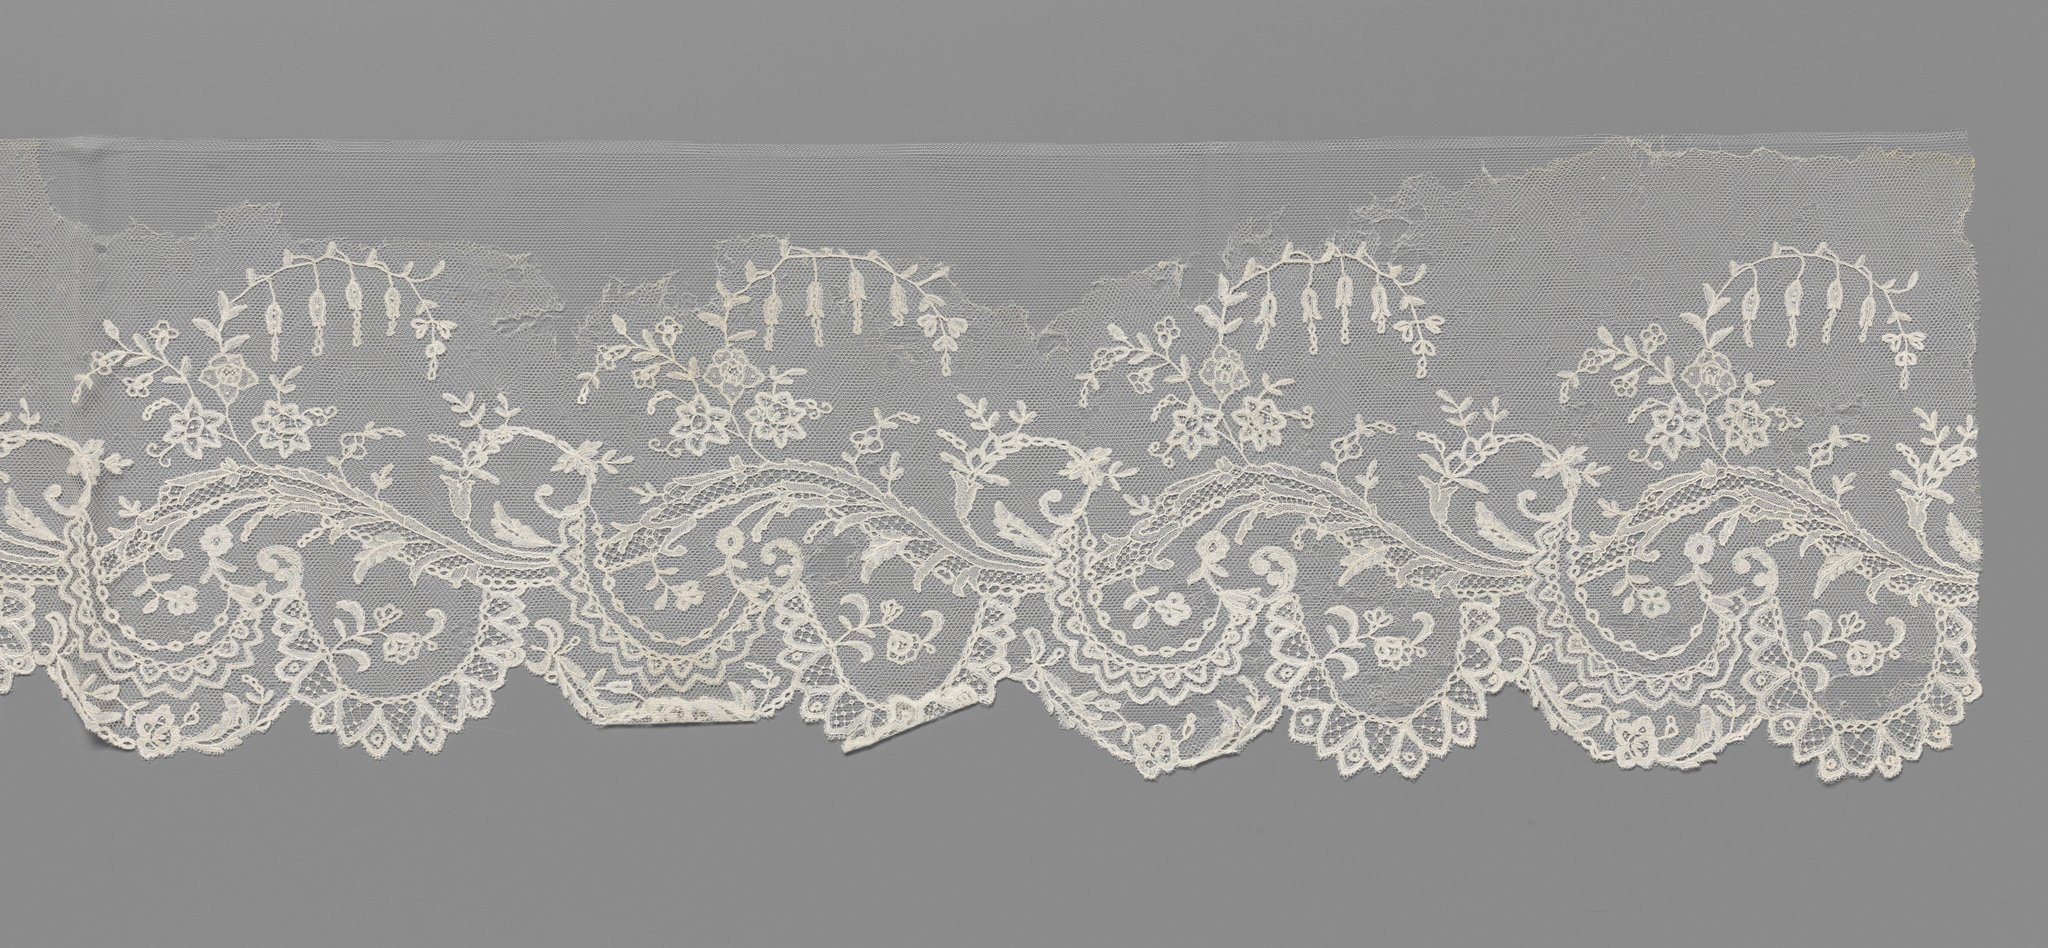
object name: strip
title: Japonstrook van applicatiekant met golvende rank en klokjesbloemtakken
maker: Anonymous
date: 1835-1849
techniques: lace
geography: brussels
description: Japonstrook van Brusselse applicatiekant, kloskant met naaldkant siersteken, bevestigd geappliceerd op machinale tule. De strook is gemaakt als bovenste strook van drie stroken voor een crinolinejapon. Op de strook staat een doorlopend patroon met een naar links golvende en opengewerkte bladrank. Uit elk golftop ontspringen drie rozetbloemen en een grote naar rechts buigende tak met klokjesbloemen. Onder één golf hangen steeds twee rijk versierde slingers, die de diepe schulpen vormen. De motieven zijn gemaakt in linnenslag en de motieven zijn grotendeels voorzien van reliëfcontouren gemaakt met een dikkere draad en hier en daar voorzien van gekloste reliëfcontouren (ribben). Eén soort siergrond (naaldkant), met verdikte knopen versierde mazen, vult een deel van de motieven. De bovenrand is afgewerkt met een zoompje.